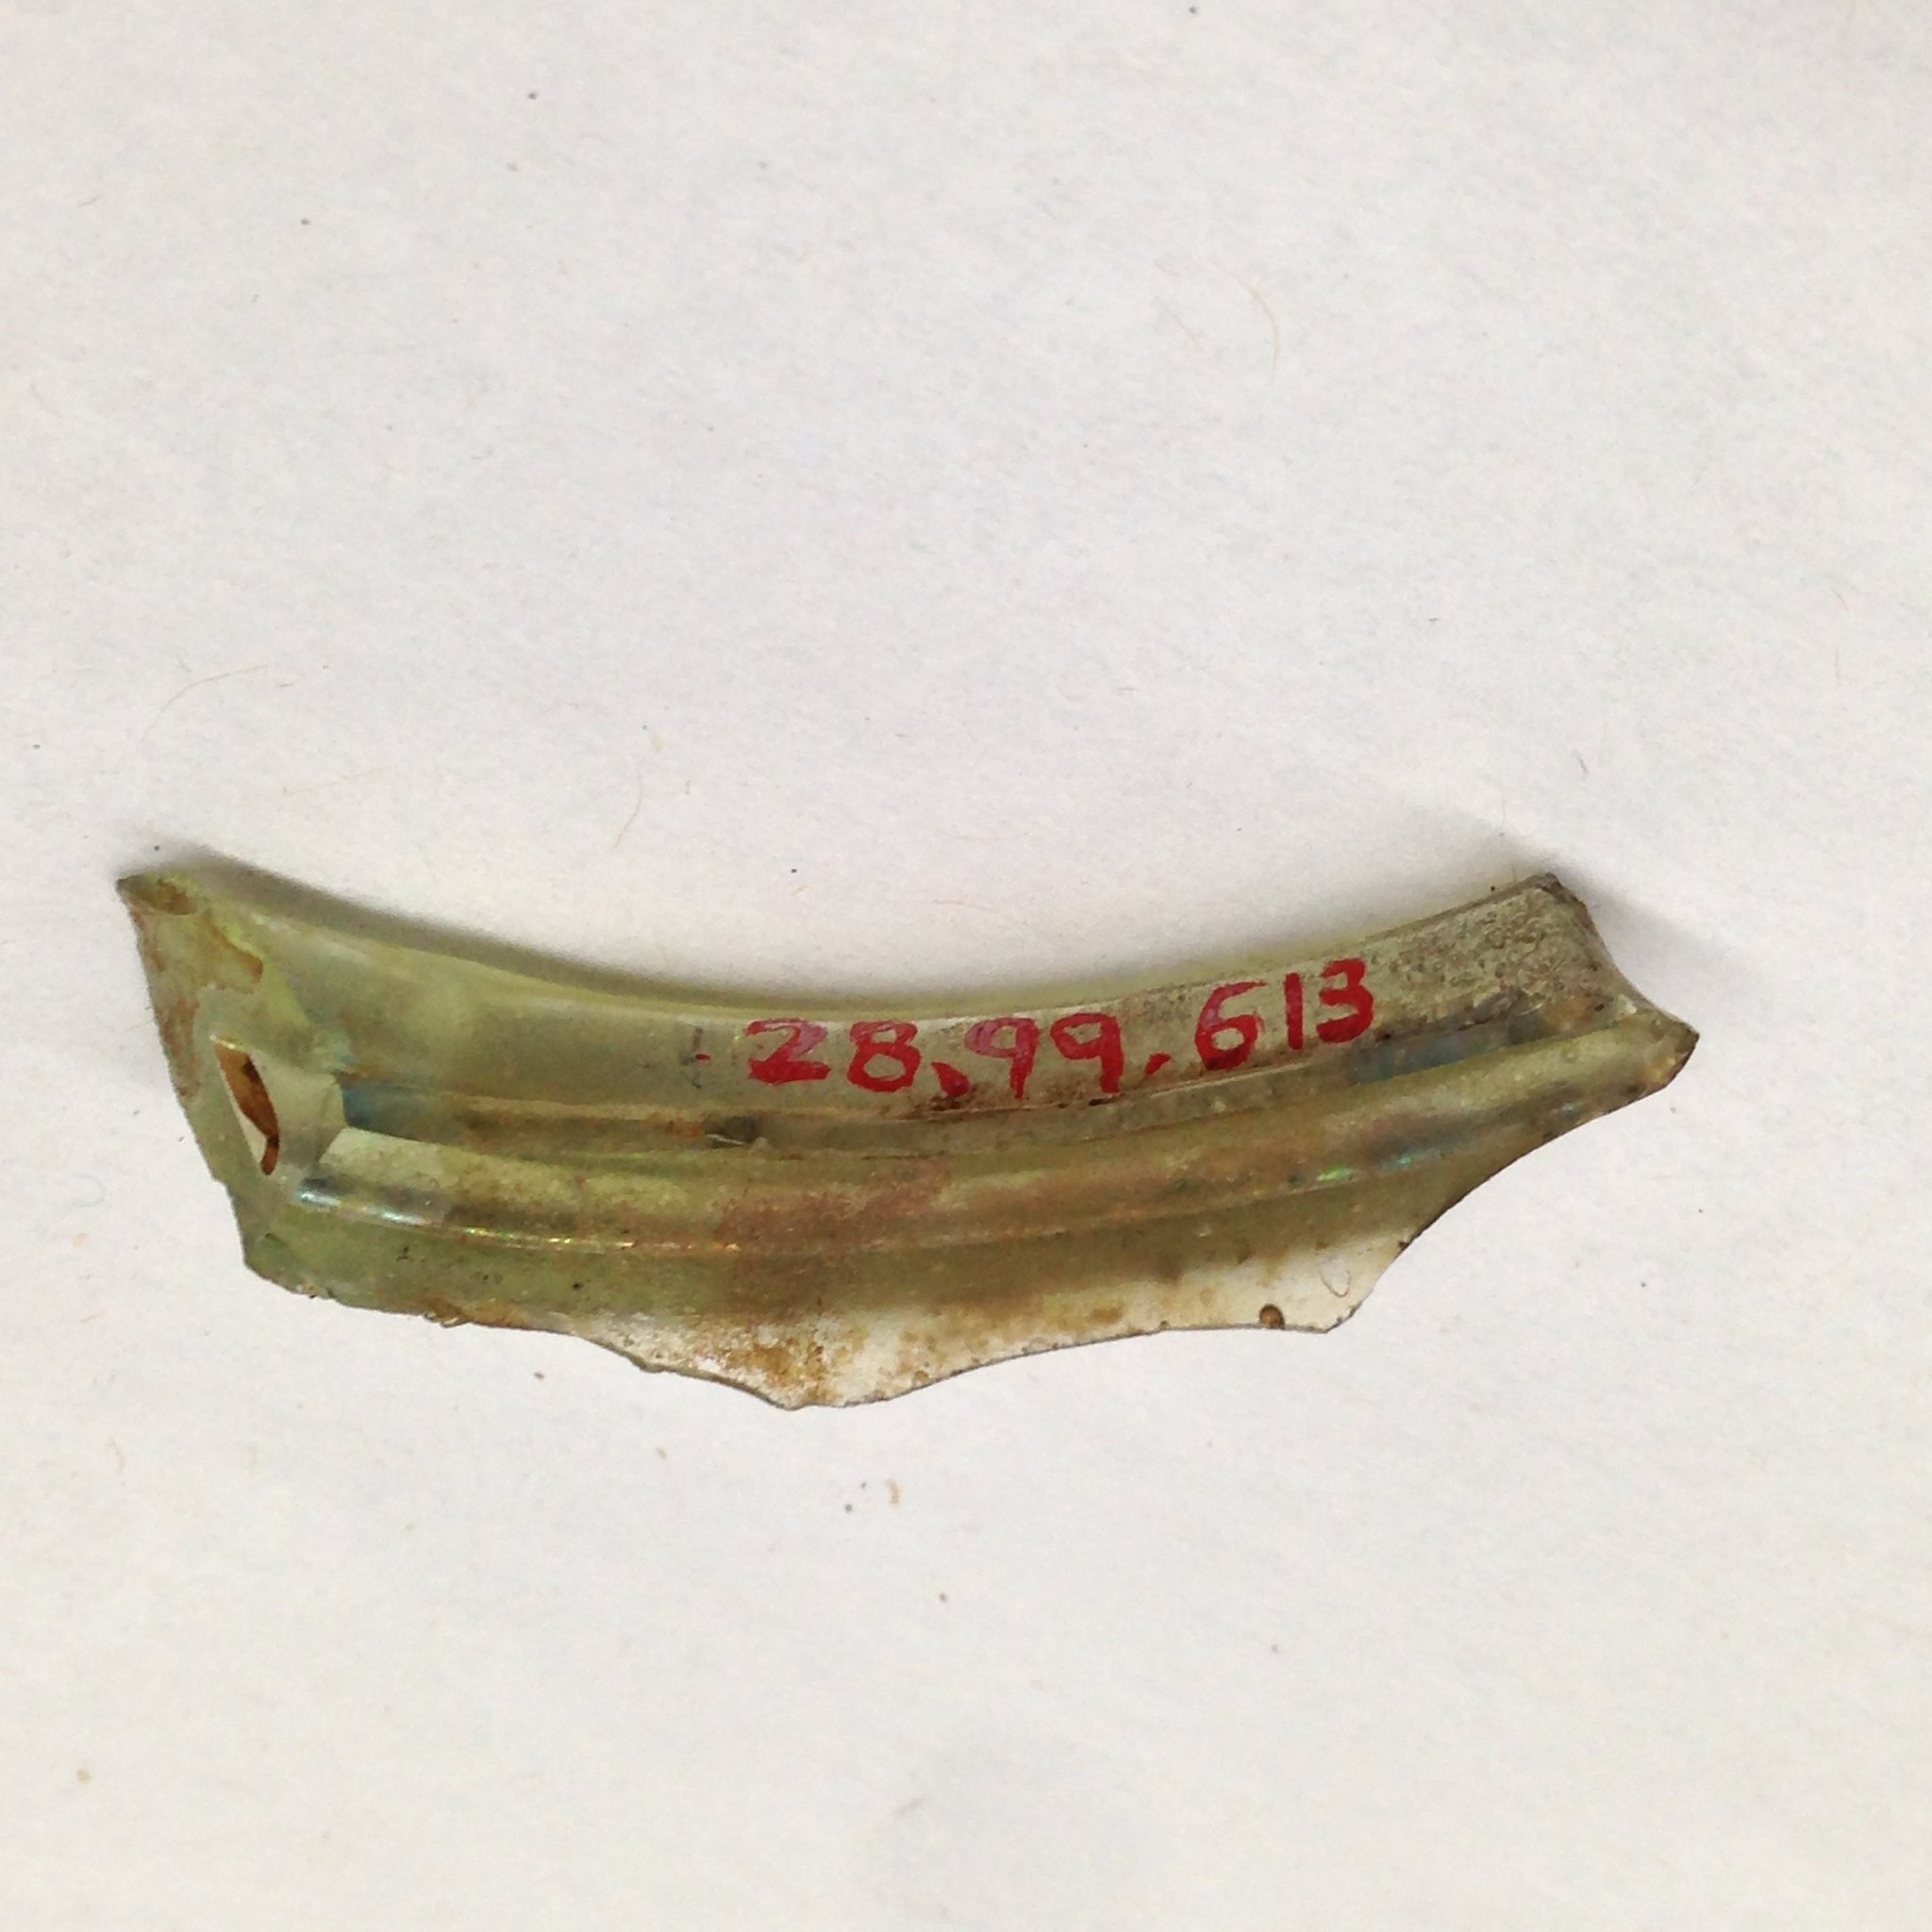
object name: fragment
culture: european or middle eastern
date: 1150-1250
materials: ceramic, glass